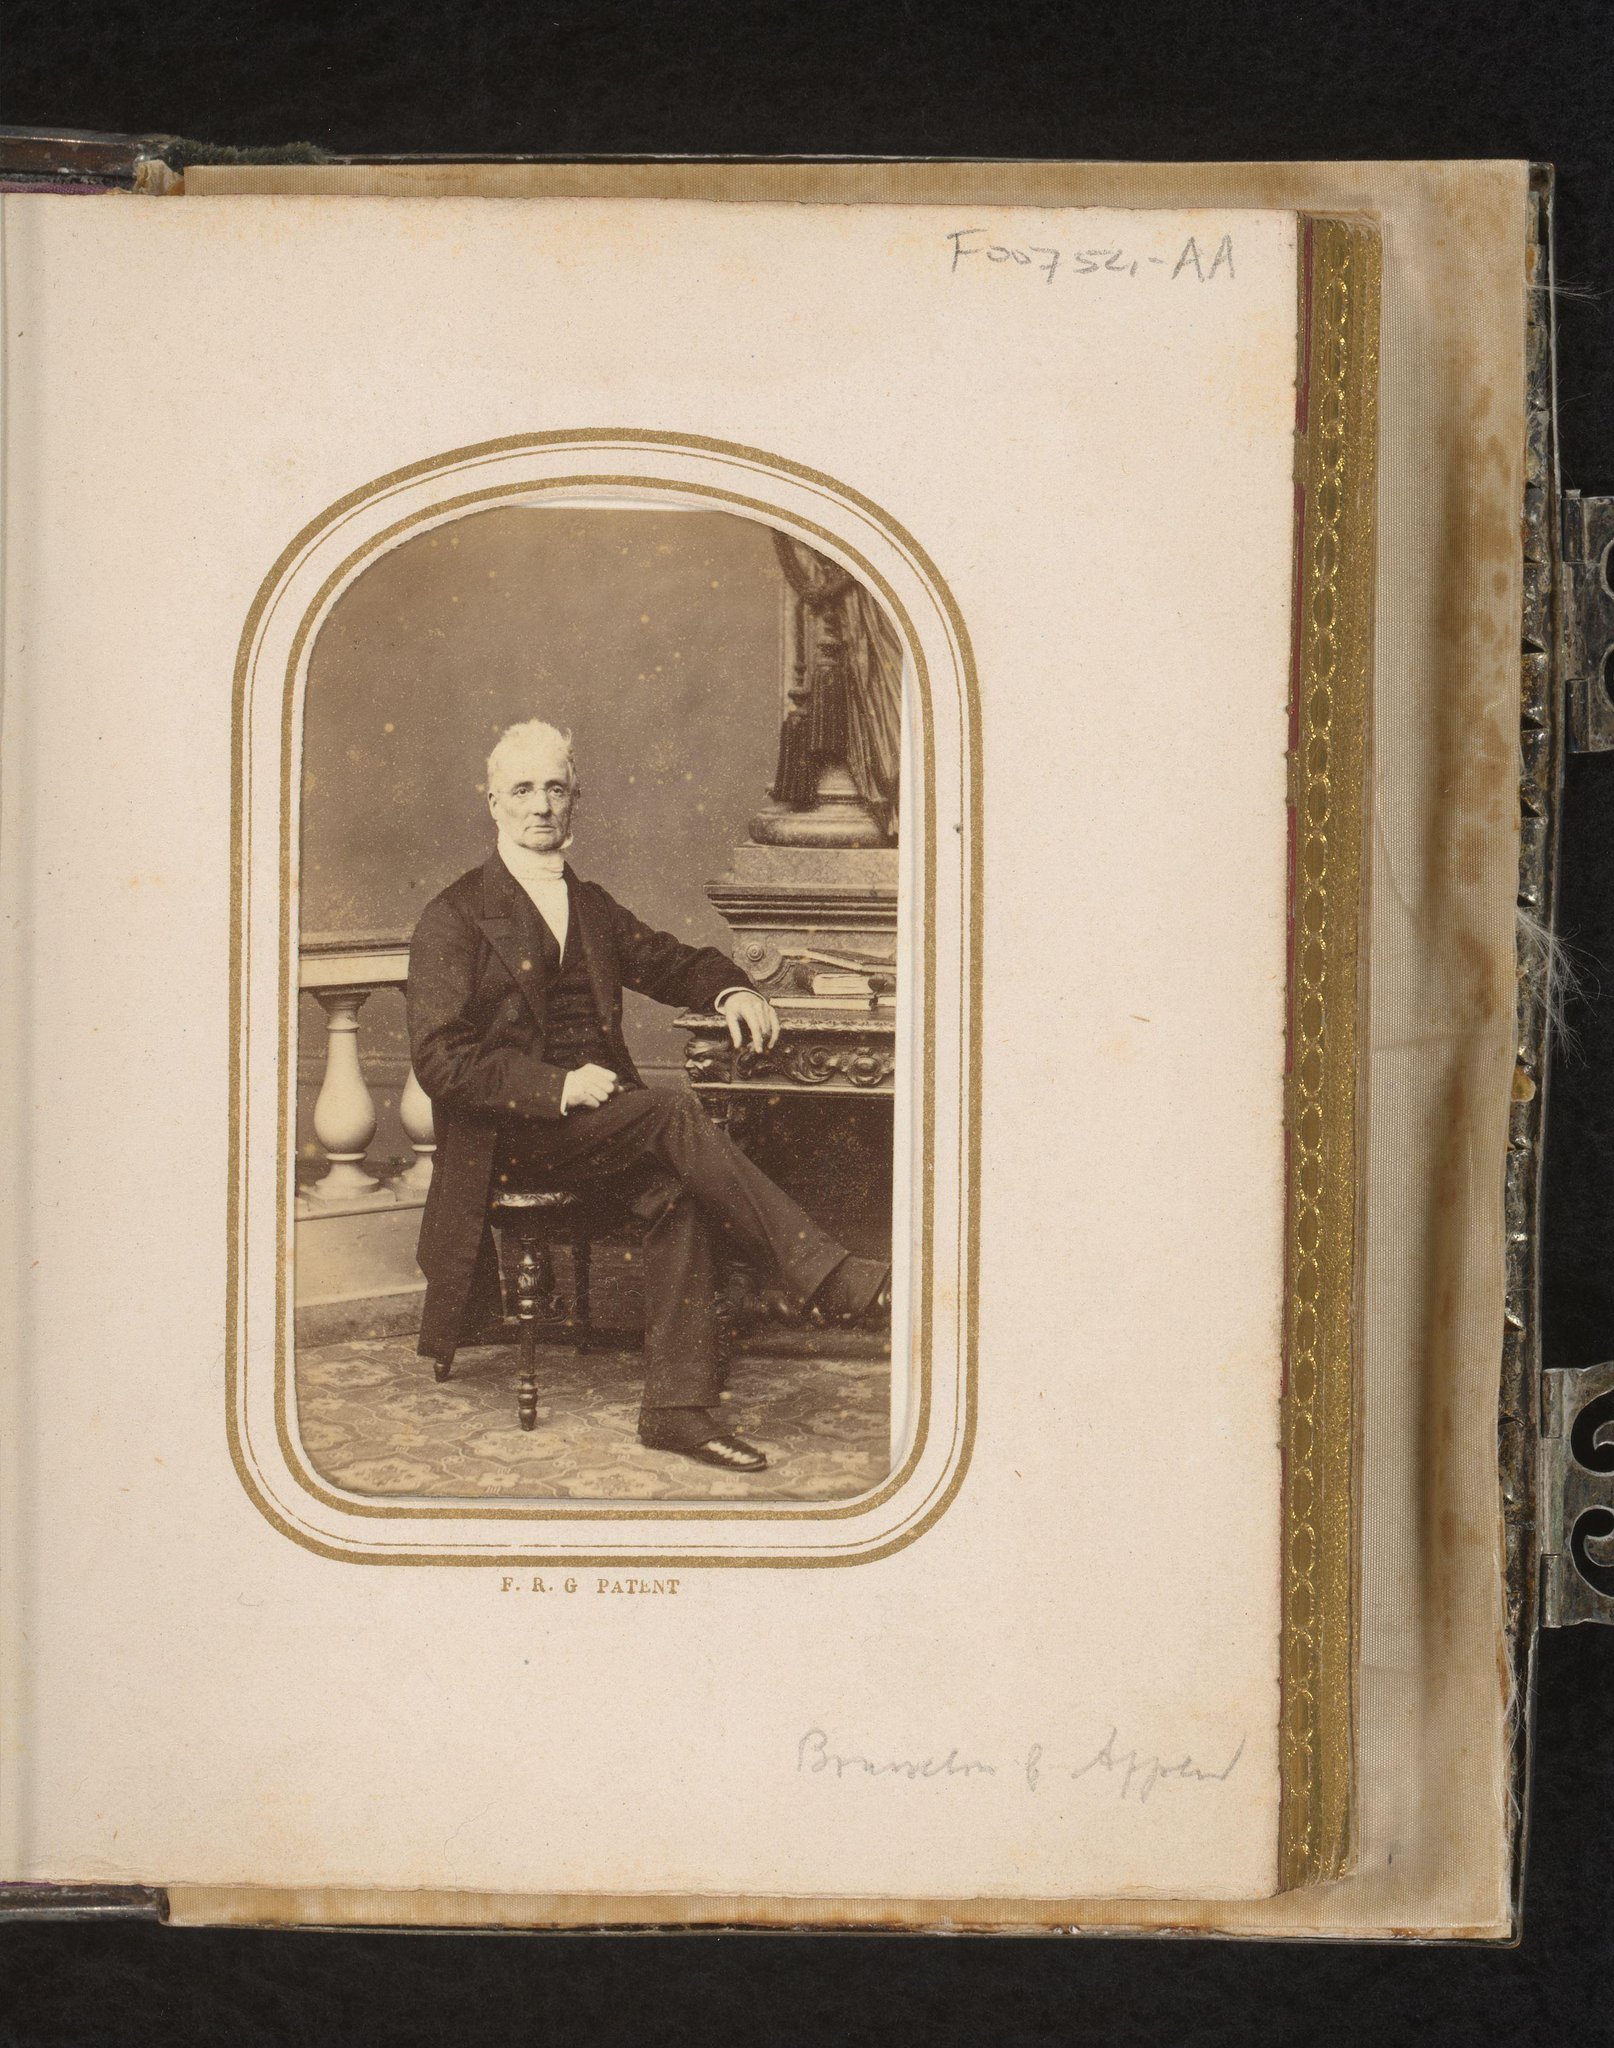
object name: photograph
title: Portret van een zittende man bij een tafel met boeken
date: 1855-1865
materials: cardboard, photographic support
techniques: albumen print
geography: paris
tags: historical persons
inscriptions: inscription: ‘Ancne Maison E. Defonds/ Bousseton & Appert/ peintres photographes (...) 21, Rue Louis le Grand/ au 1er étage/ Paris’